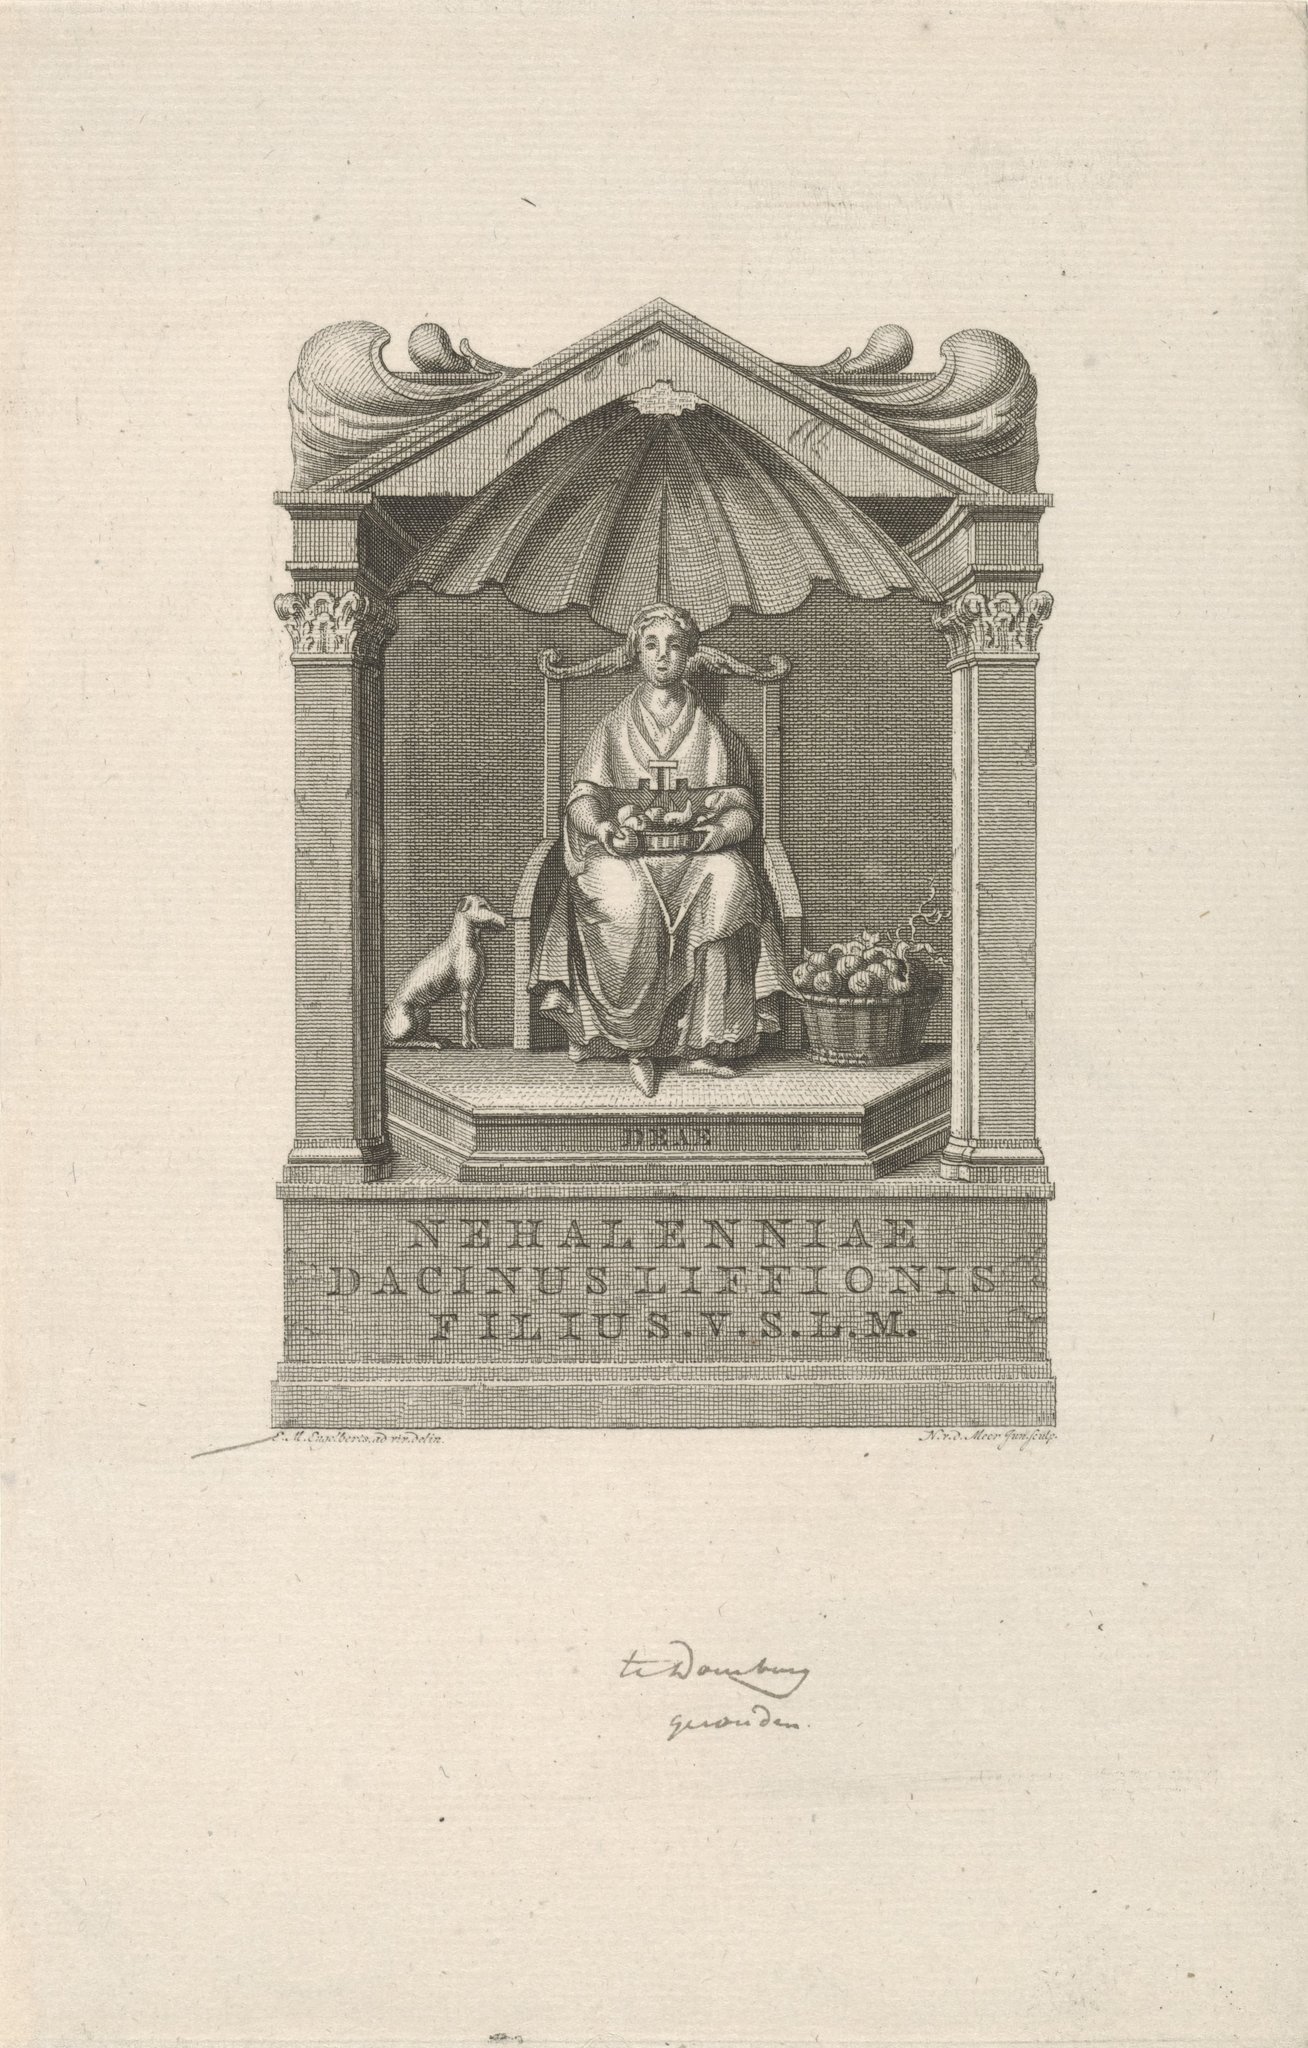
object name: print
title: Altaar voor Nehalennia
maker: engelbertus matthias engelberts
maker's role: draughtsman, print maker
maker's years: 1731-1807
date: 1751-1822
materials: paper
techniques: etching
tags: other foreign deities included in the classical pantheon (with name)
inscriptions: inscription: ‘te Domburg gevonden’, collector's mark: Lugt 2228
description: Een altaar gewijd aan de godin Nehalennia, die in de tweede en derde eeuw na Christus in Zeeland werd aanbeden. Zij heeft een mand met appels op haar schoot en een mand met appels en een hond aan haar zijde. Bodemvondst uit Zeeland.